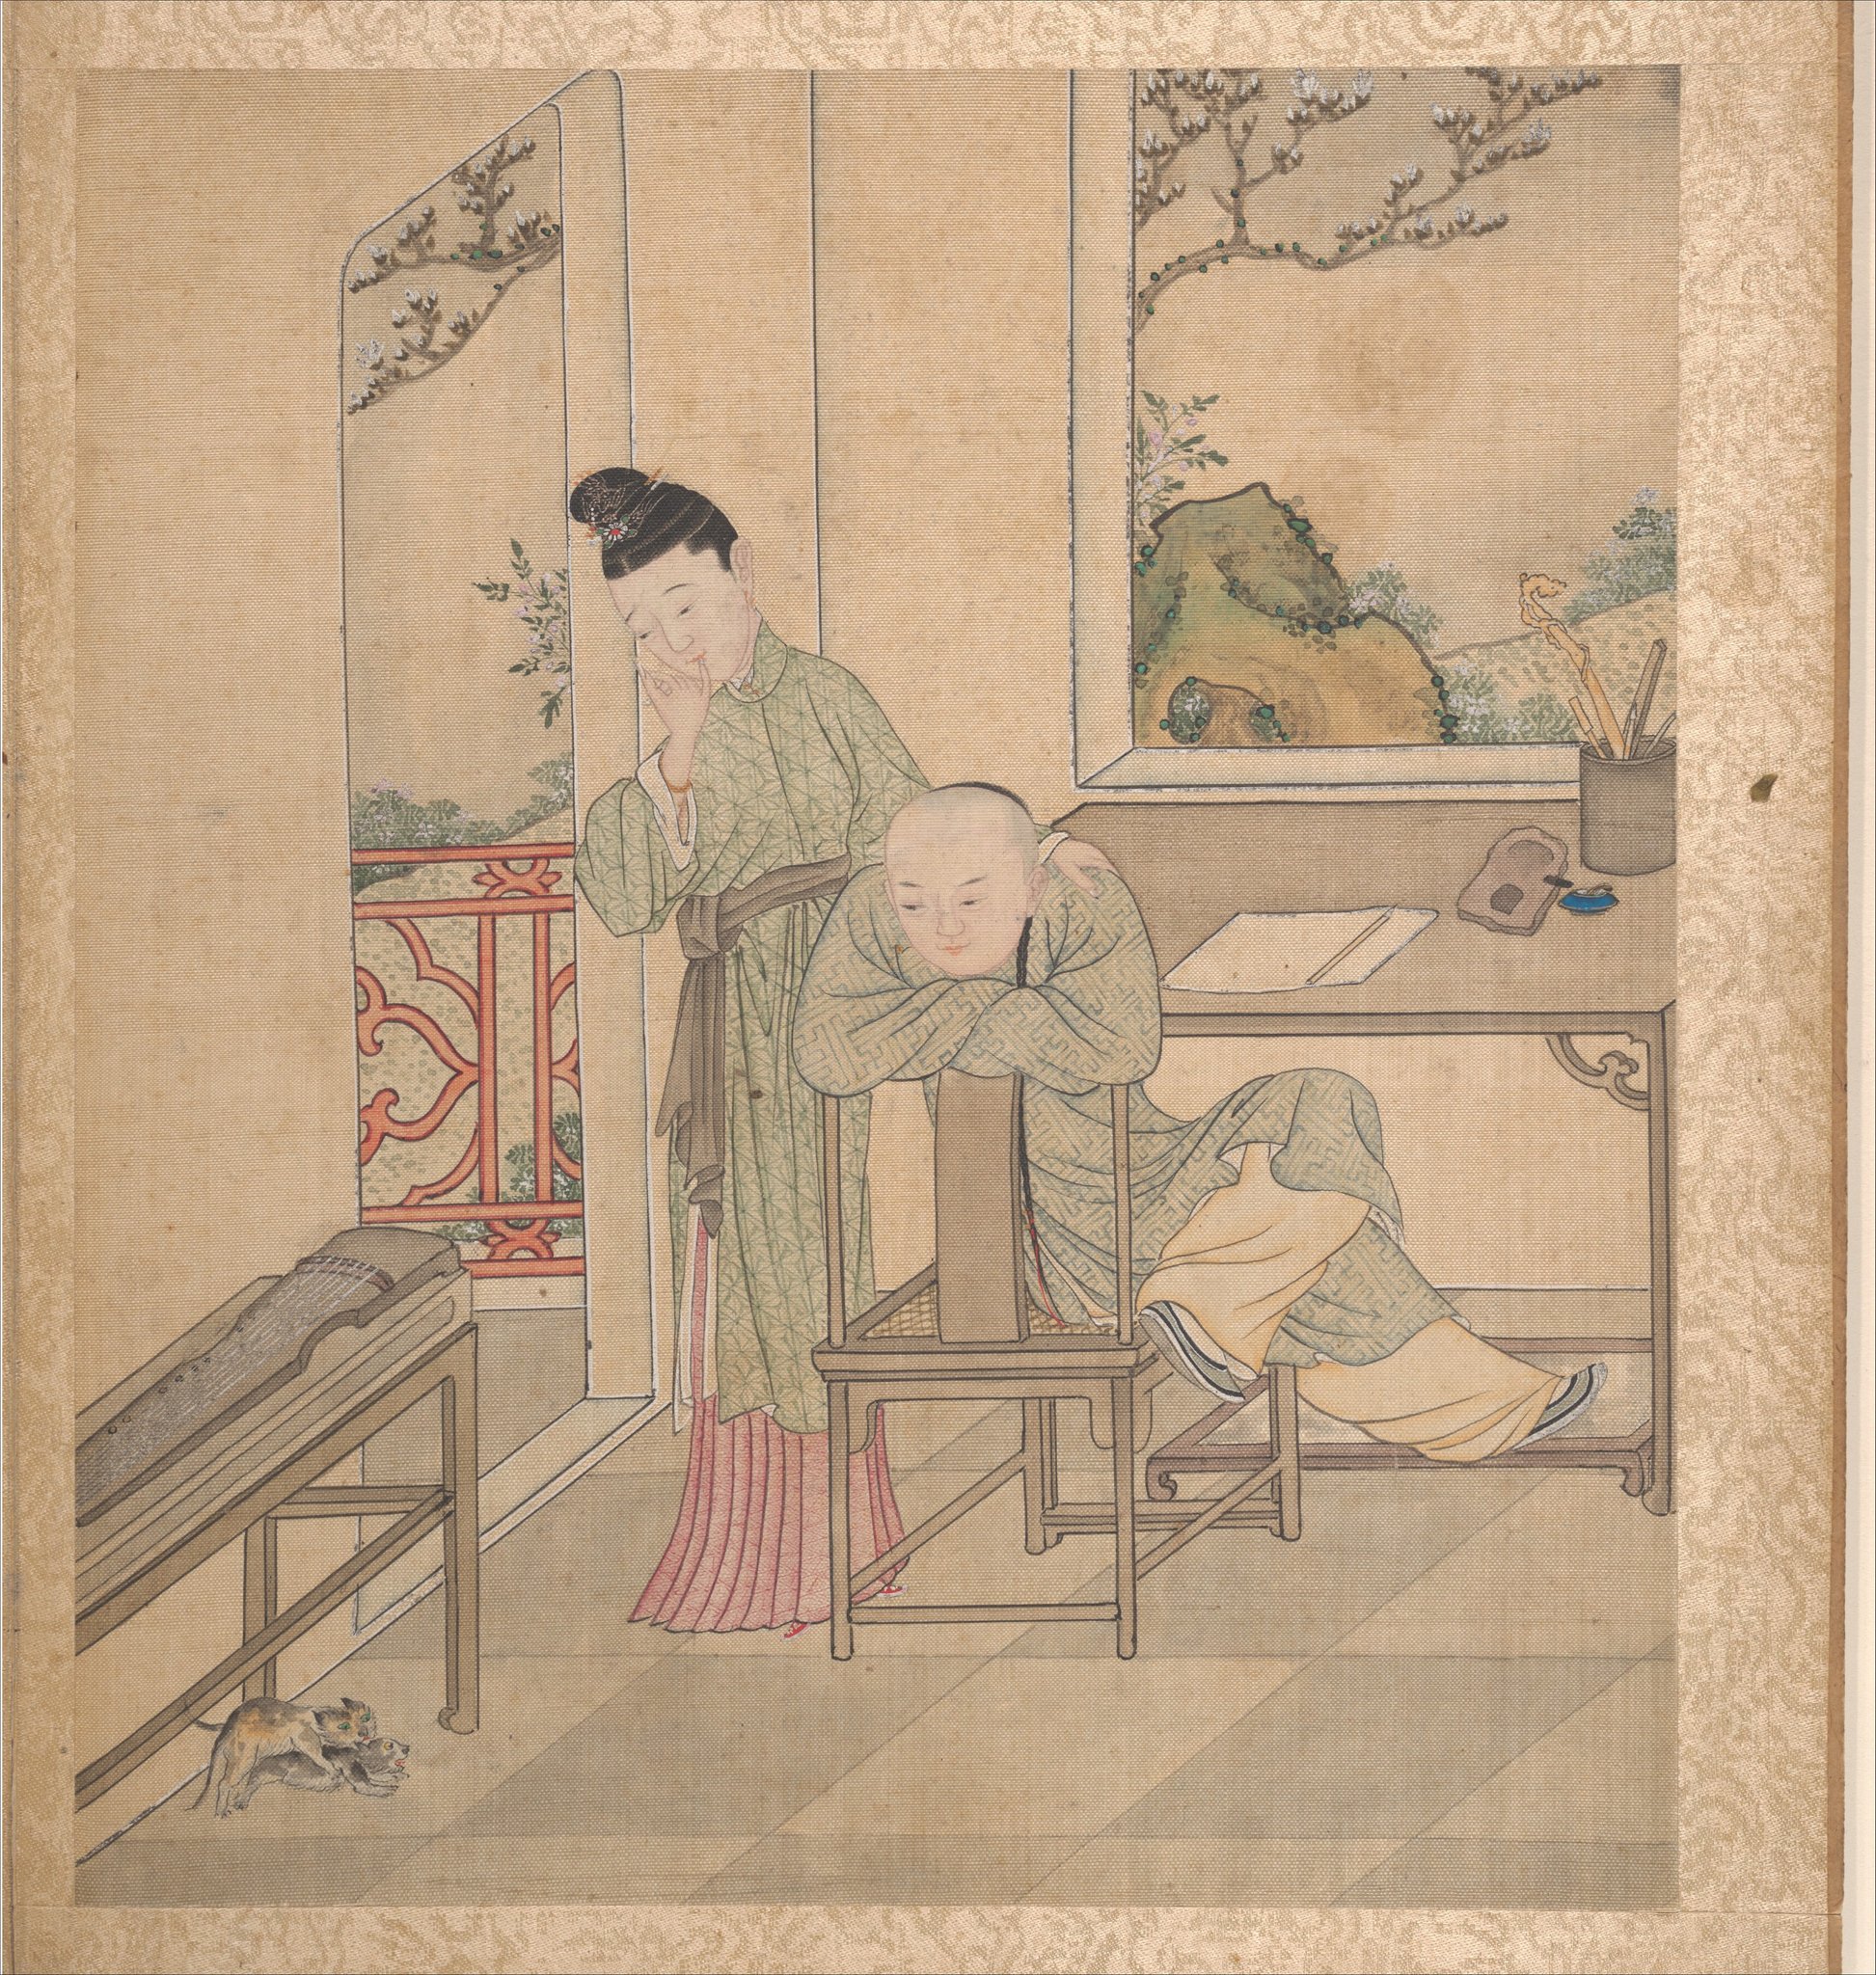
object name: album leaf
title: Spring Pictures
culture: chinese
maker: unidentified artist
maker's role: artist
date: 1644-1911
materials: ink, silk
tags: men,women,cats,chairs,tables